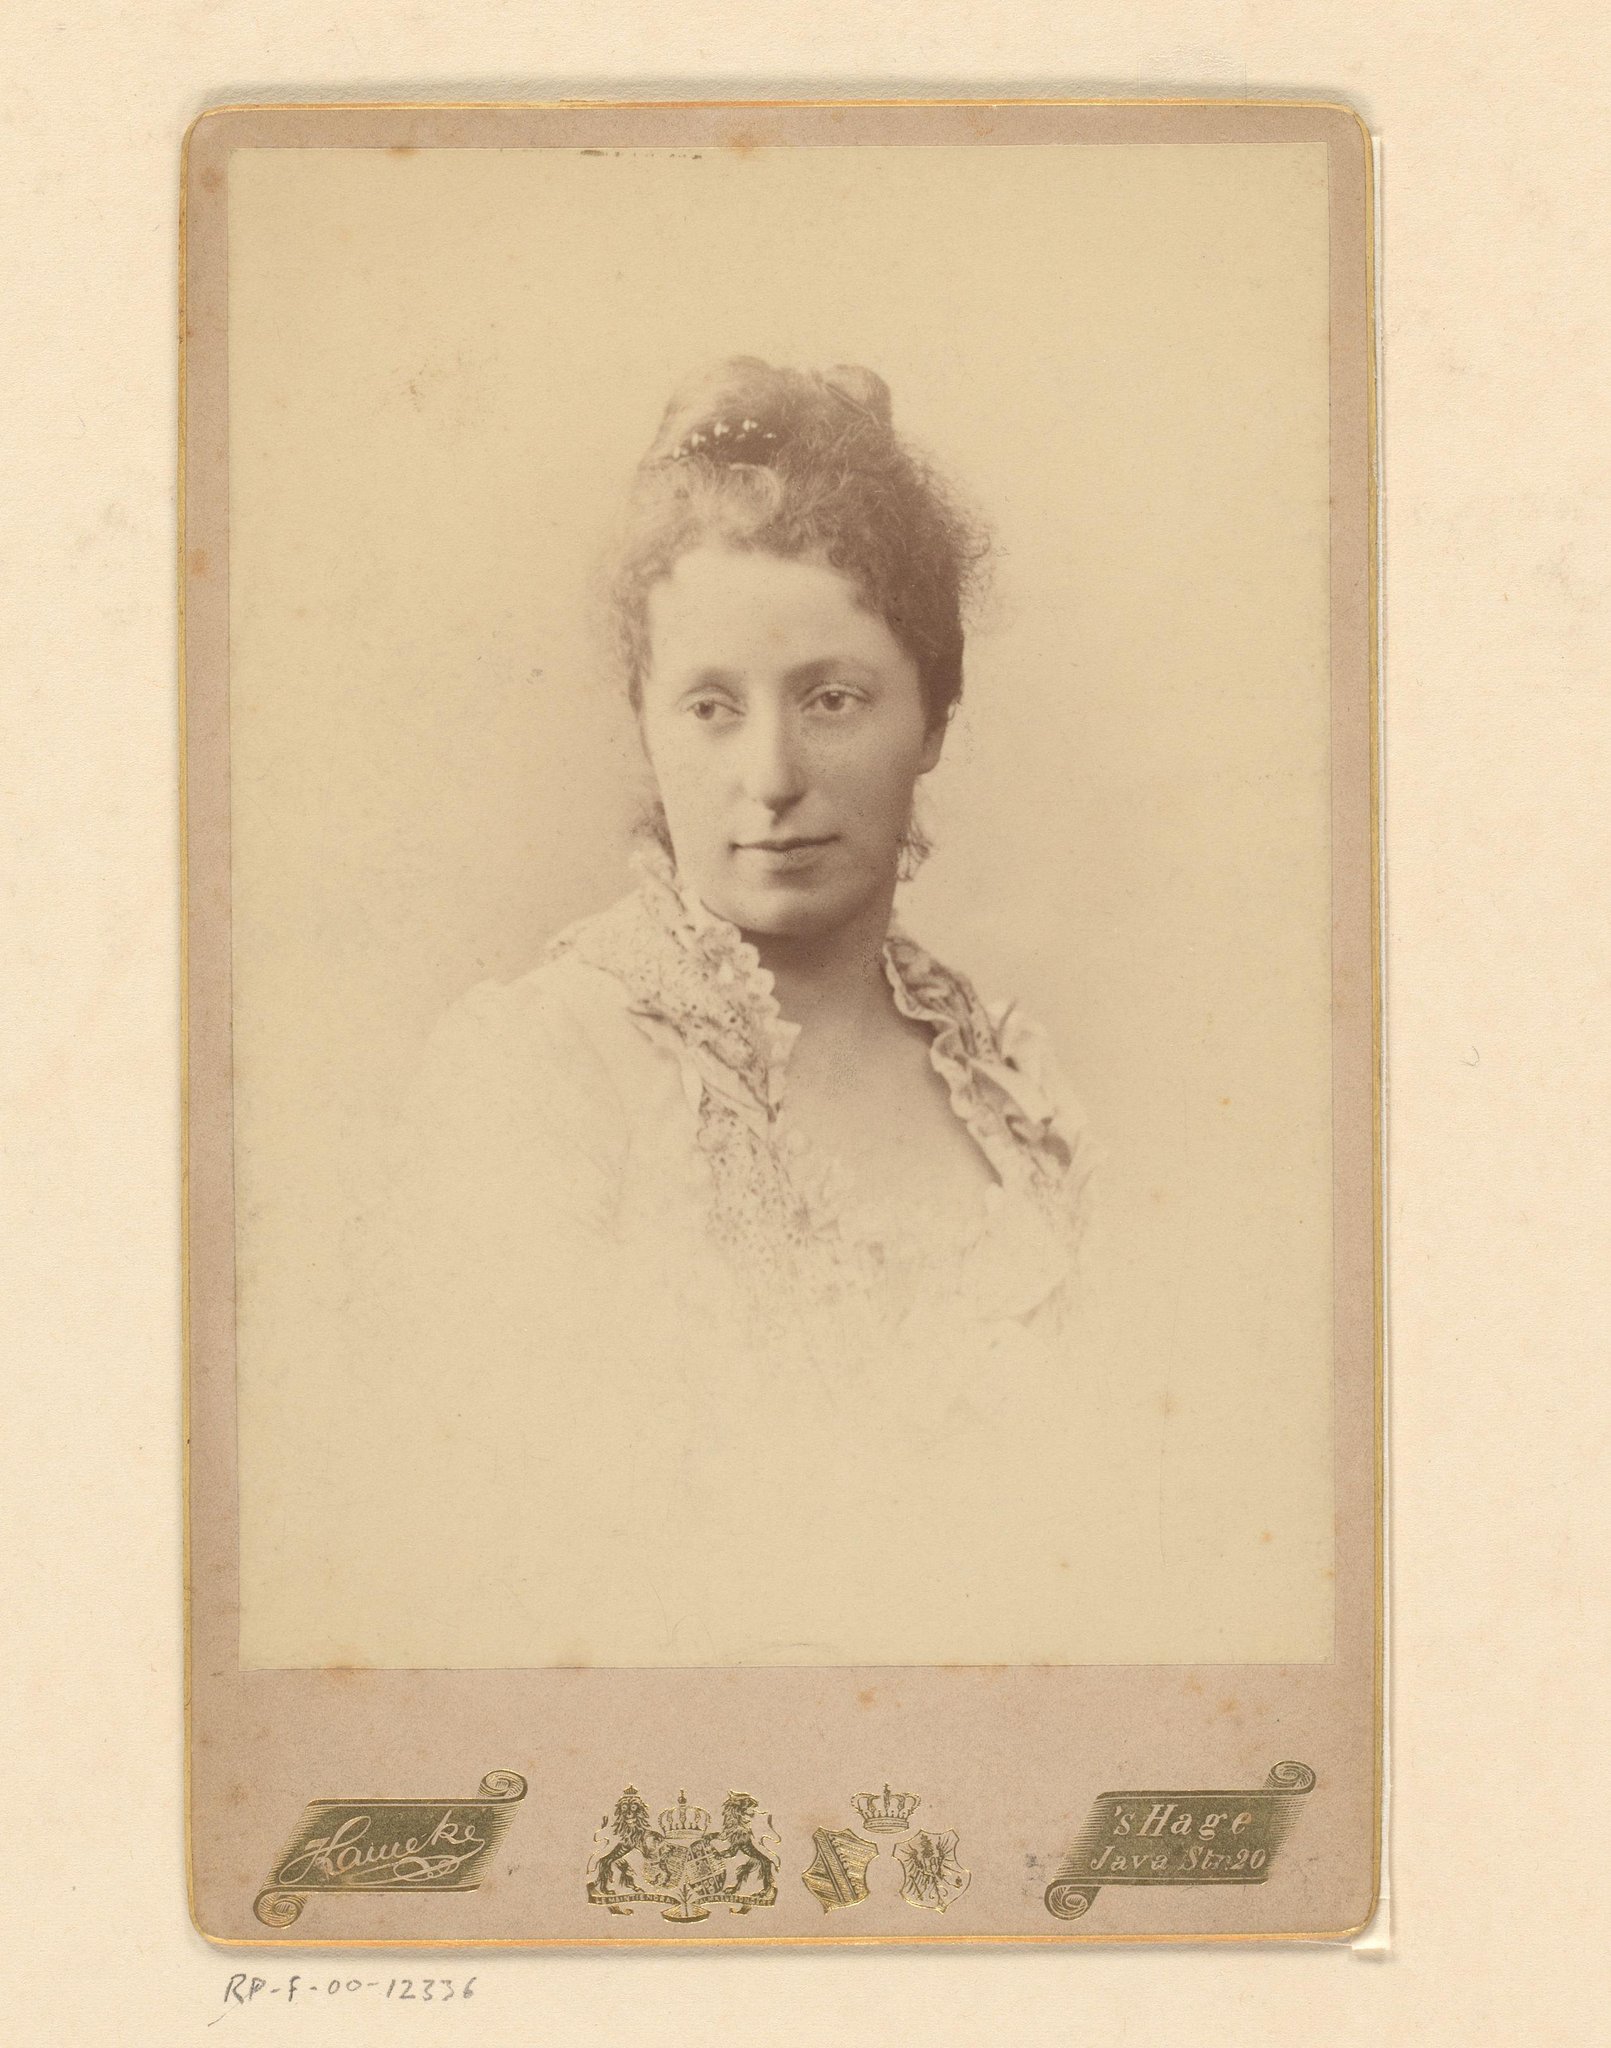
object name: cabinet photograph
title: Portret van Bramine Hubrecht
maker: richard kameke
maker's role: fotograaf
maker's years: 1847-1898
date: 1887-1898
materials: cardboard, paper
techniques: albumen print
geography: the hague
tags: rotterdam, painter, print maker, draughtsman, bramine hubrecht, historical persons - bb - woman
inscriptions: address: ‘'s Gravenhage,/ JAVASTRAAT No 20/ bij de Scheveningscheweg.’